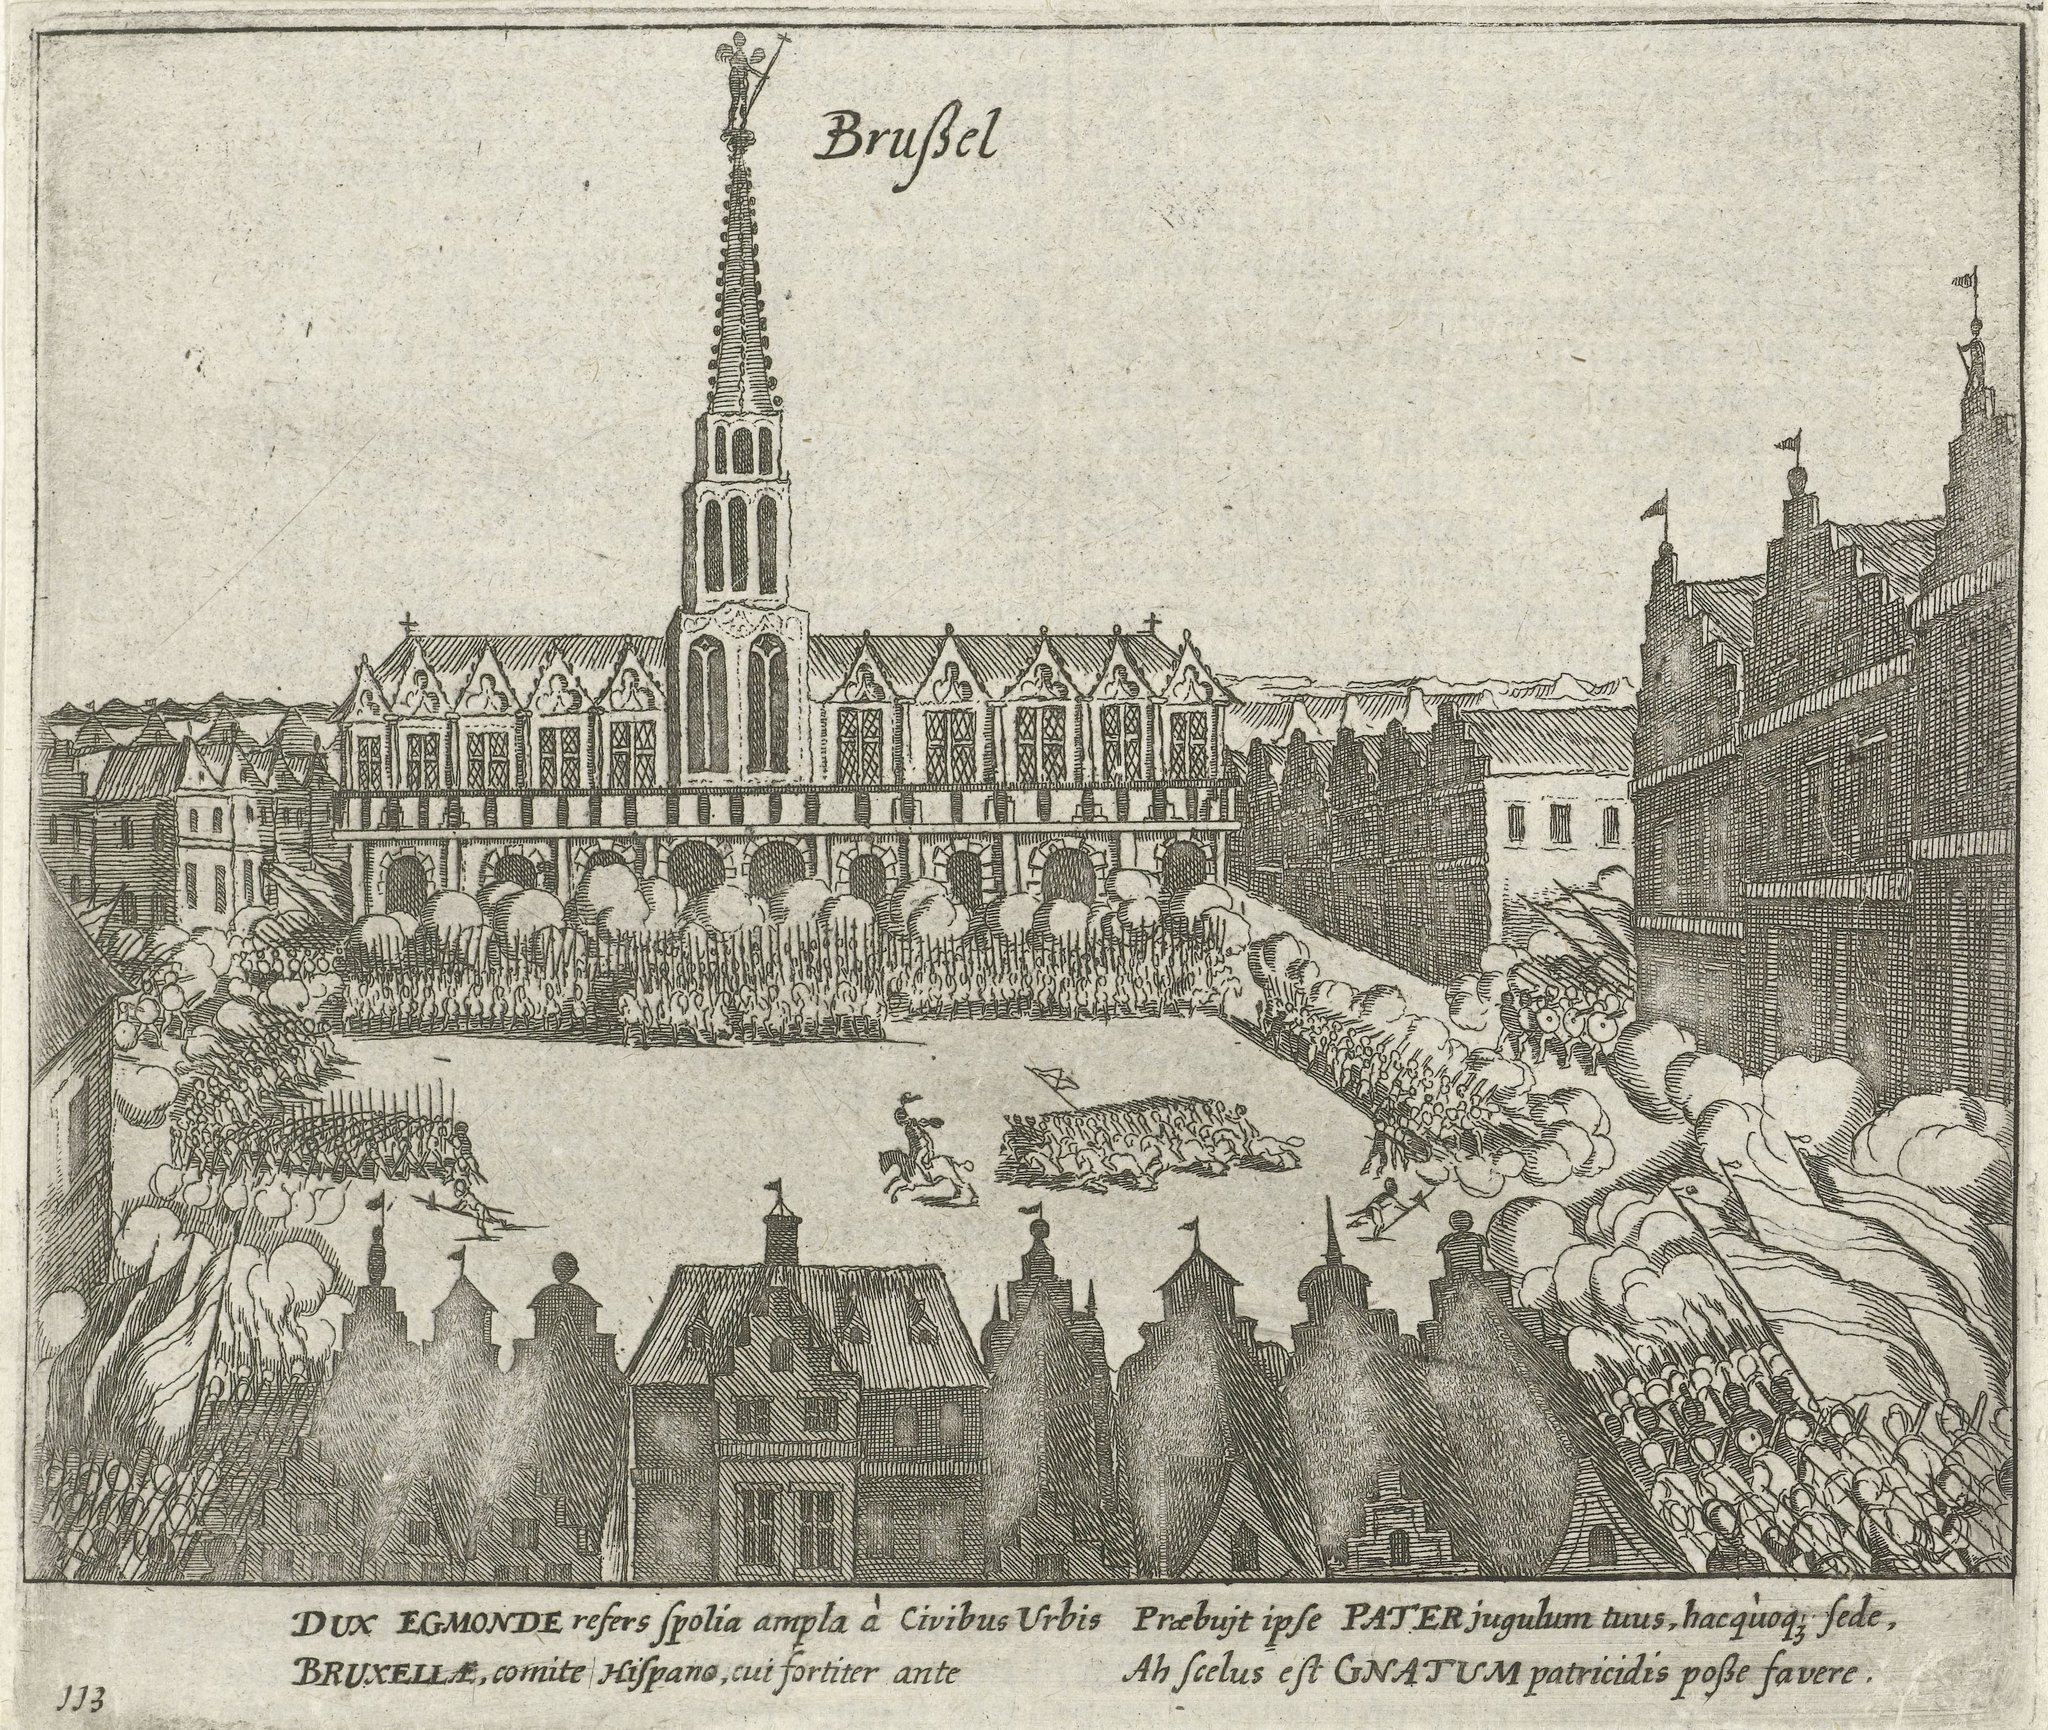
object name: history print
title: Aanslag van de graaf van Egmond op Brussel, 1579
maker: simon frisius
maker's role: print maker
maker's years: 1570-1628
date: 1613-1615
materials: paper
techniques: etching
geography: northern netherlands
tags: staatsman, kolonel, filips van egmond, grote markt, tachtigjarige oorlog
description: Aanslag van Filips graaf van Egmond op Brussel, 1579. De Grote Markt te Brussel bestormd door het leger van de graaf van Egmond, 4 juni 1579. Met onderschrift van 4 regels in het Latijn. Genummerd: 113. Bedrukt op achterzijde met tekst in het Nederlands.